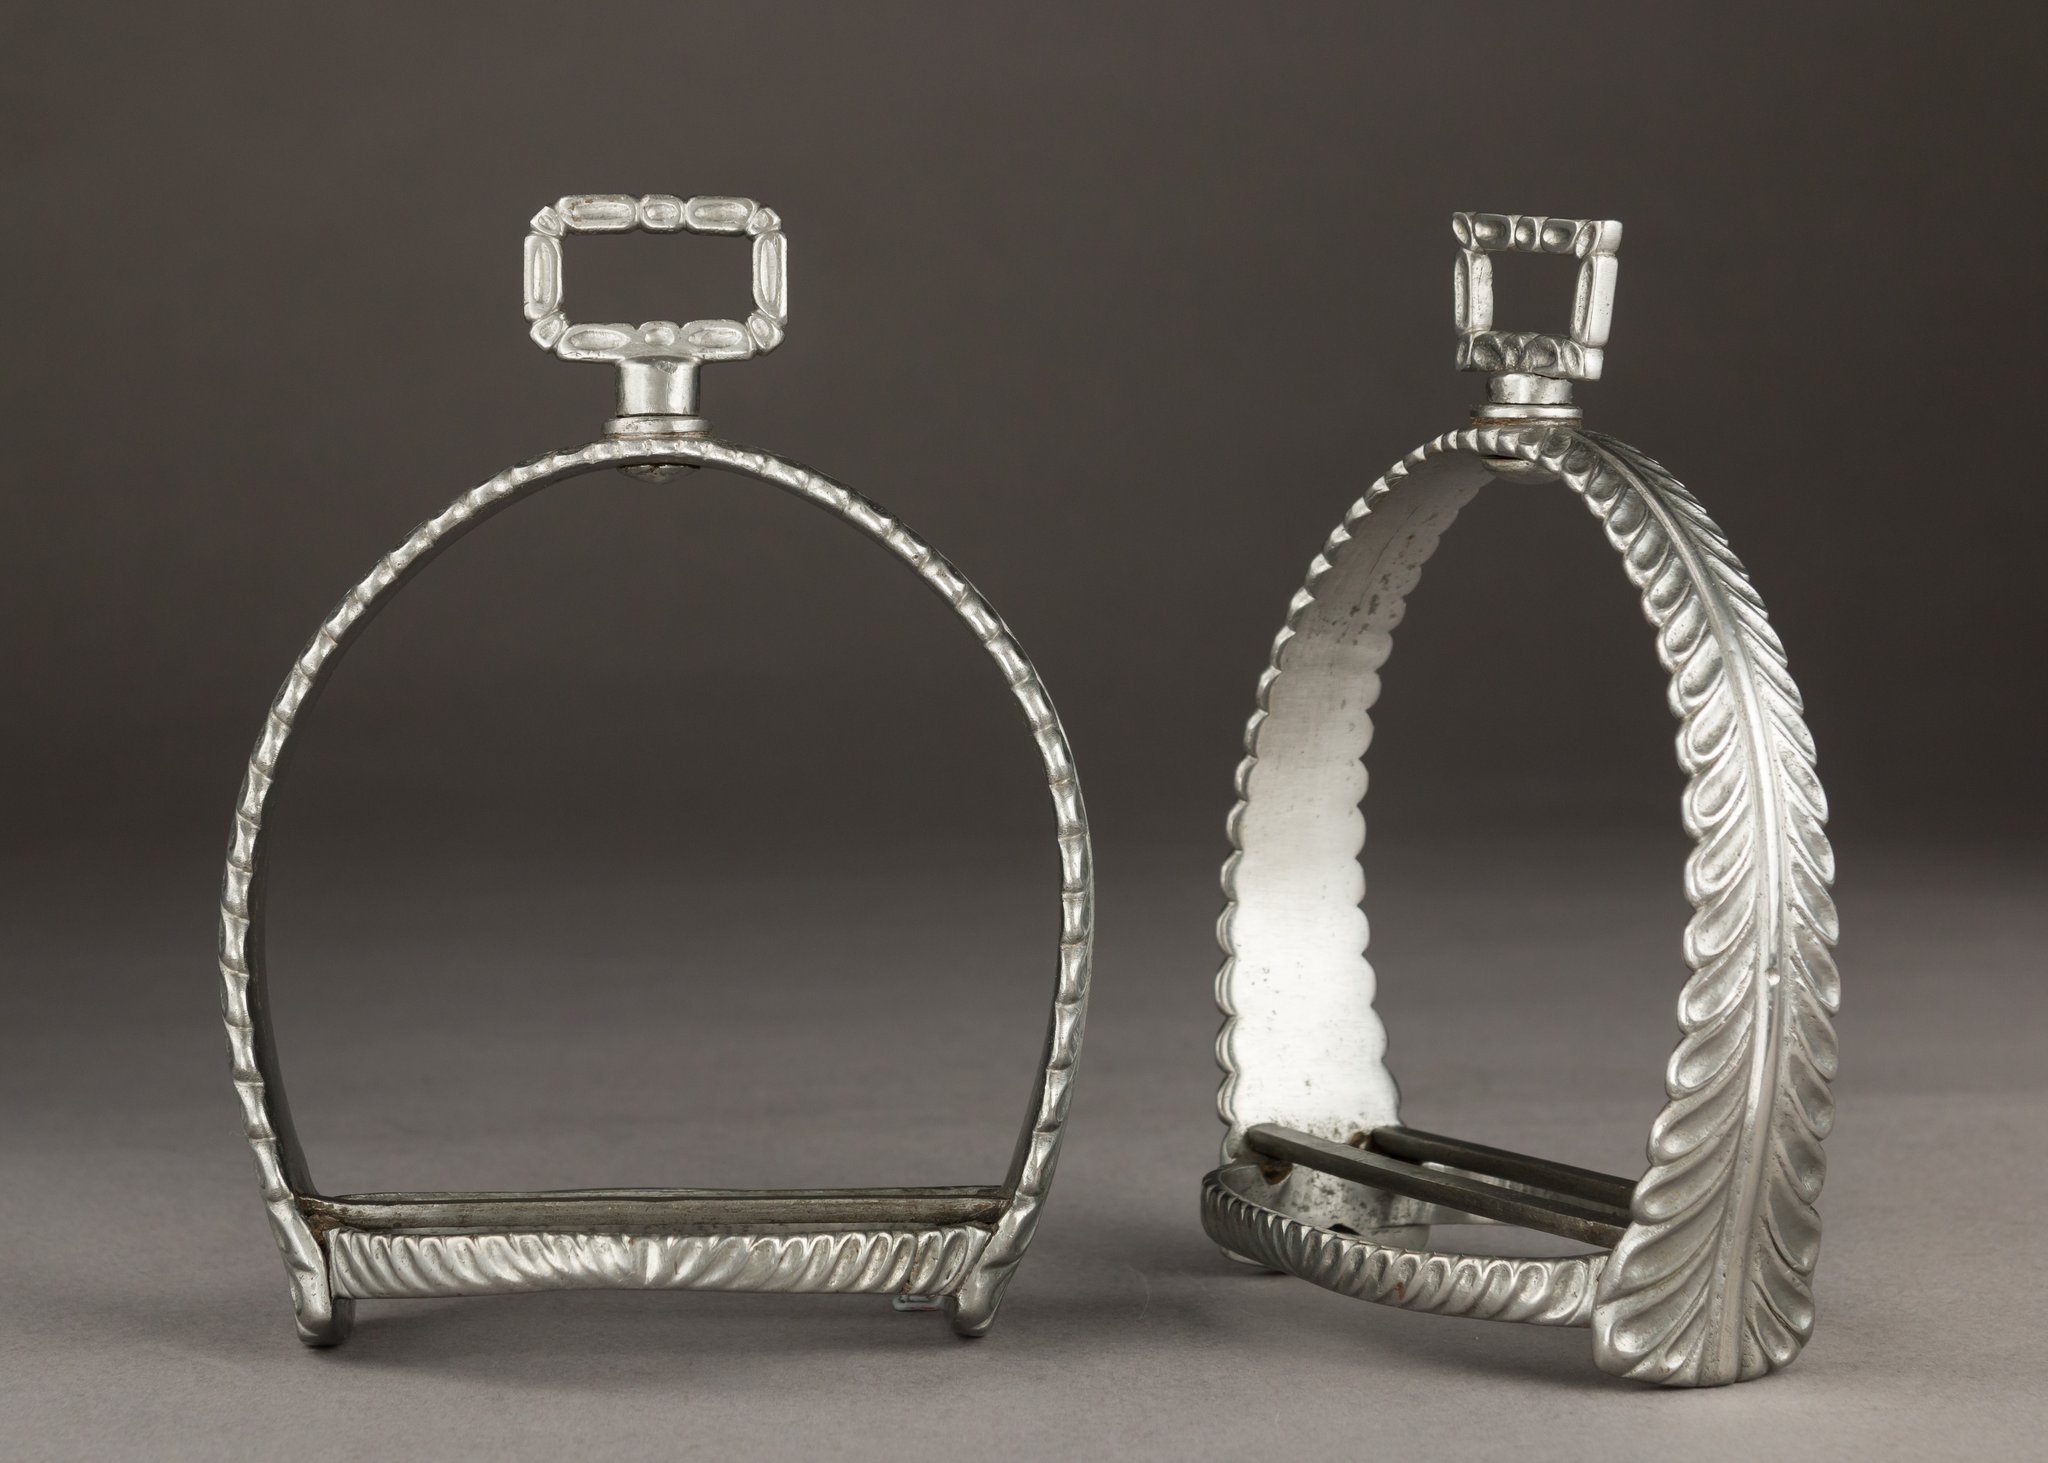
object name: stirrup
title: Pair of Stirrups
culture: italian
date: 1601-1700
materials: metal alloy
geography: italy